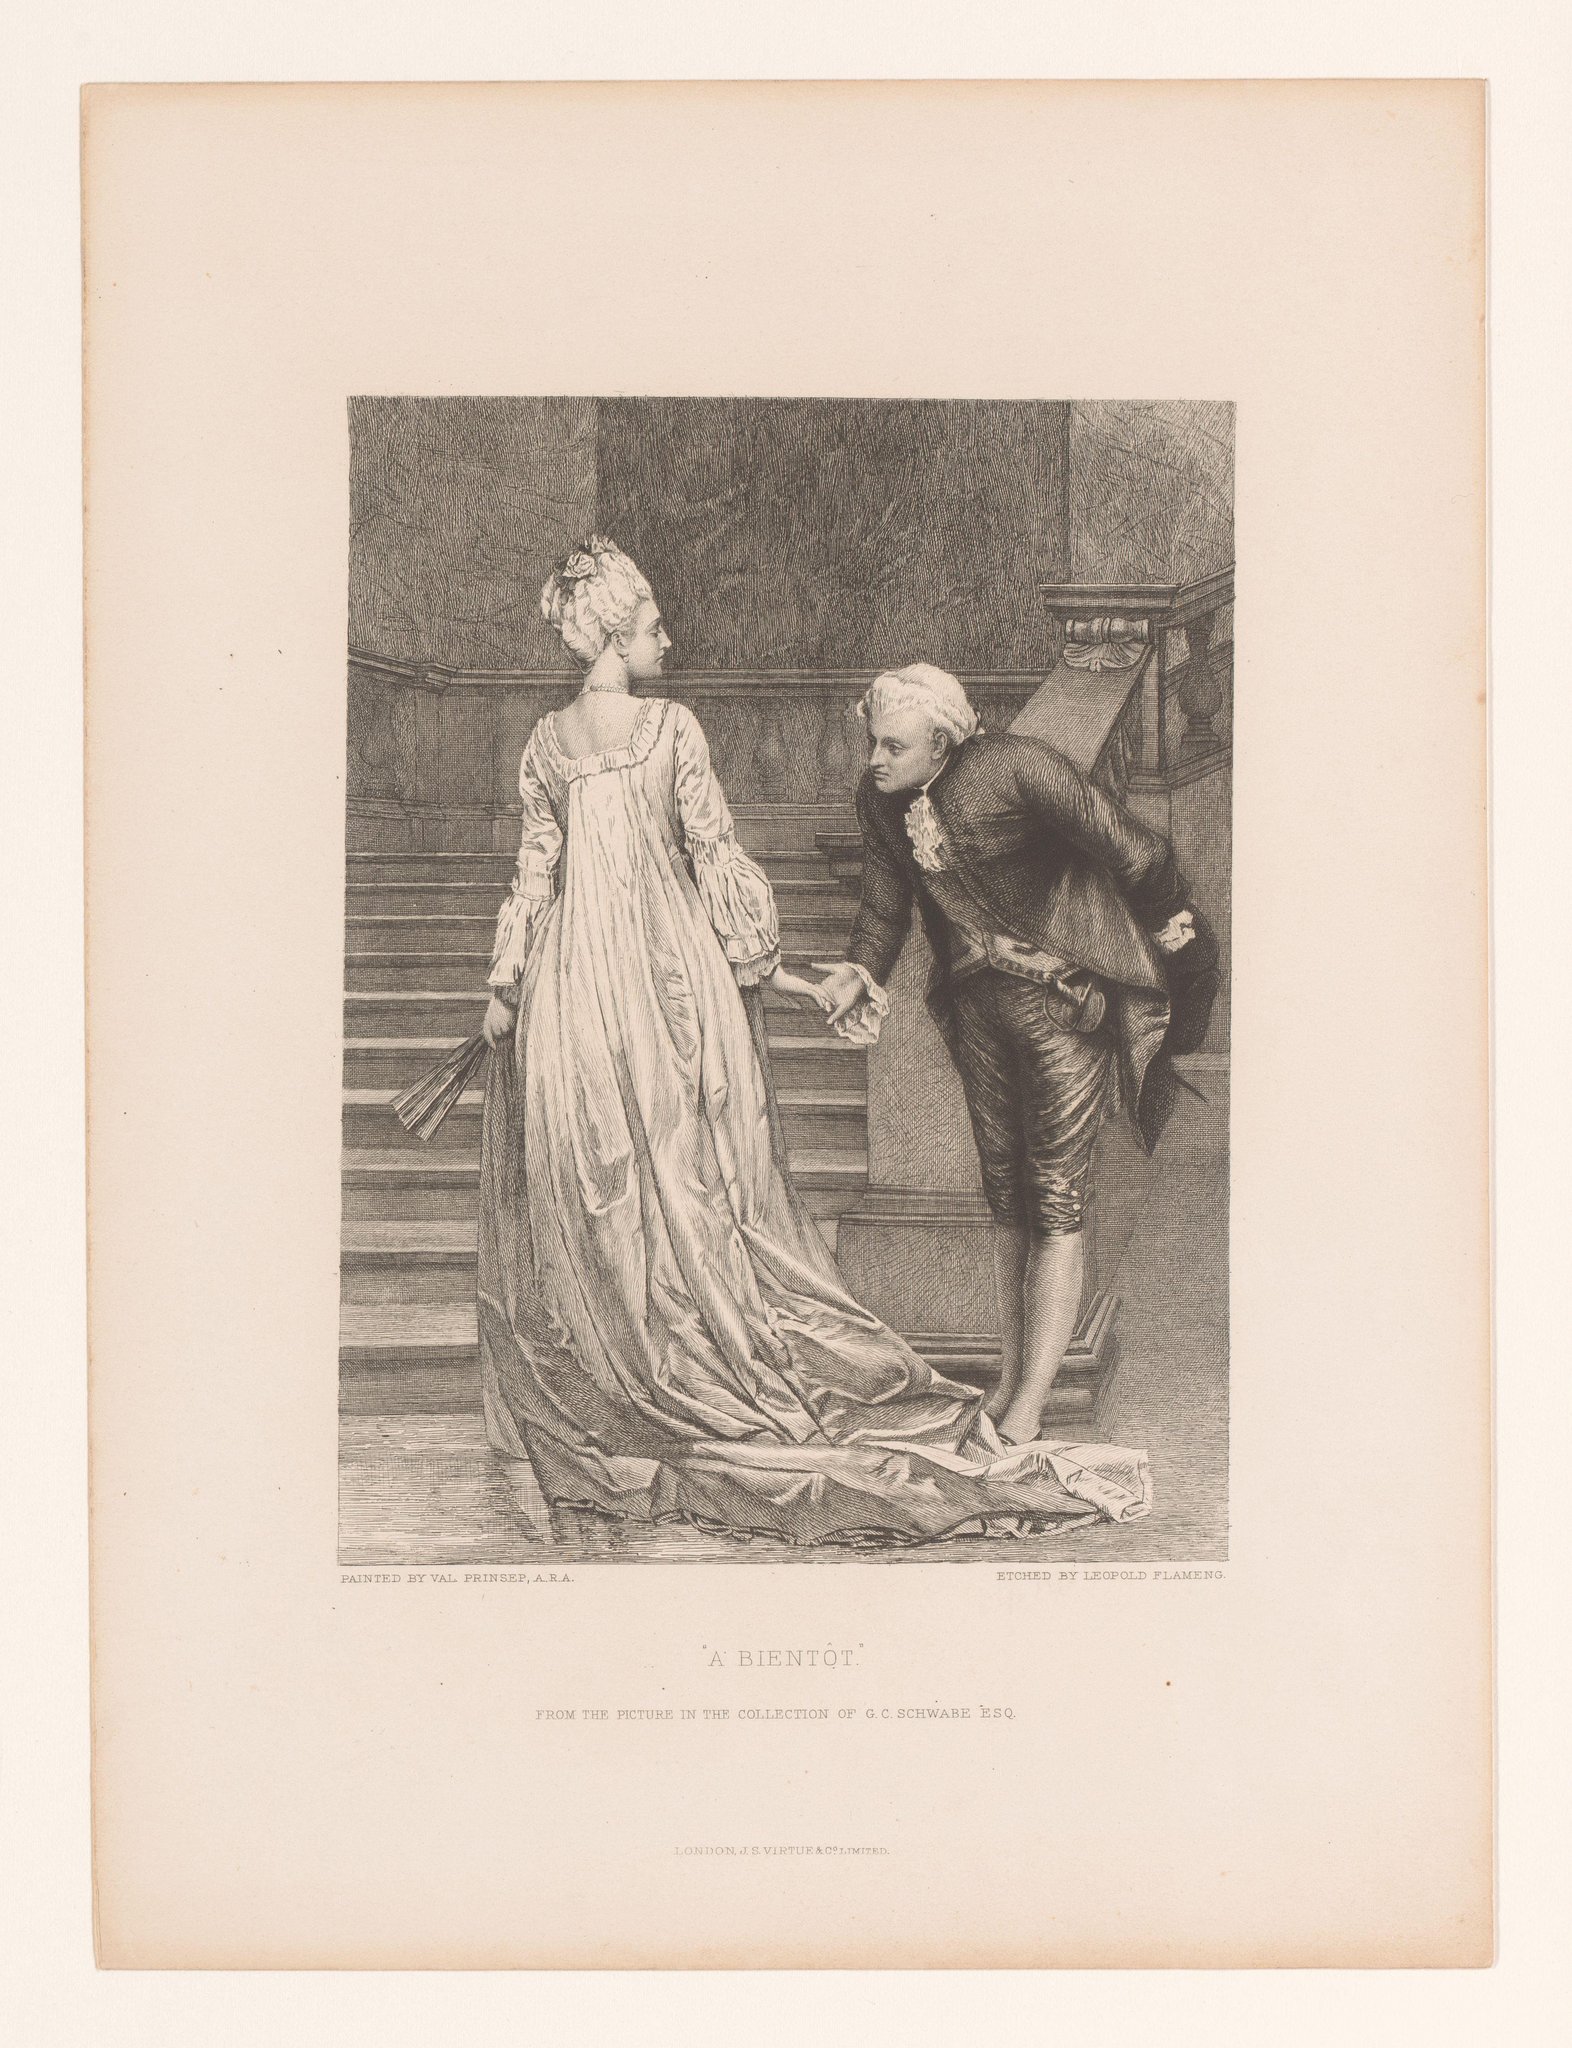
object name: print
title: Heer neemt afscheid van een dame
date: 1841-1904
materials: paper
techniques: etching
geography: london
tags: parting, leave-taking (of lovers)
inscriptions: collector's mark: Lugt 2228